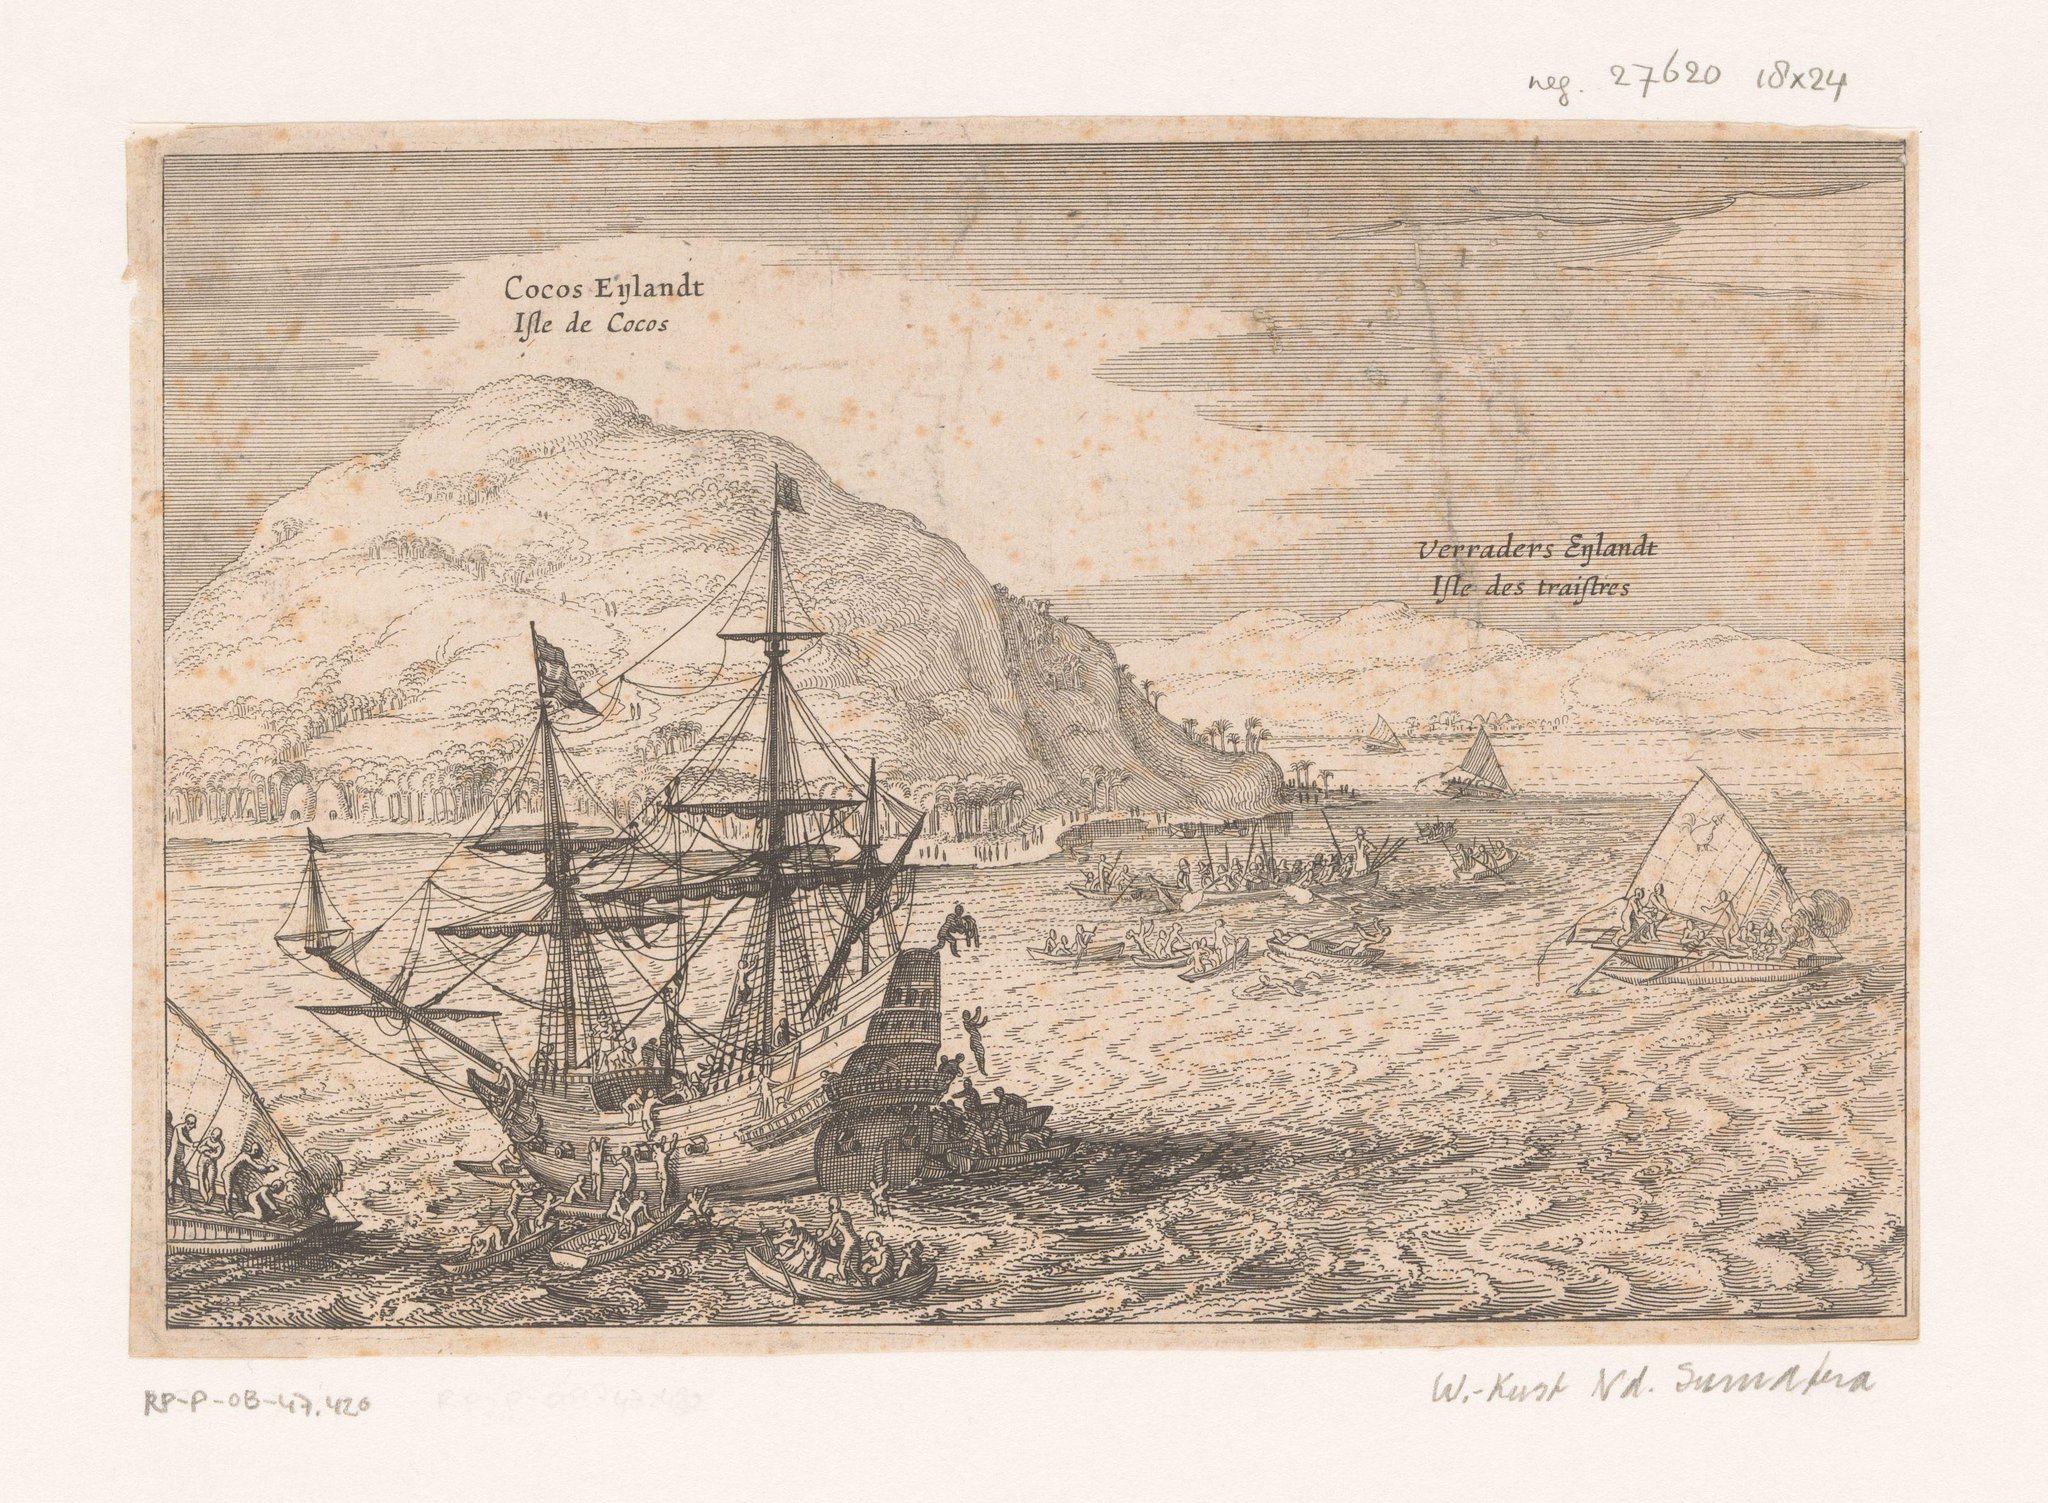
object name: print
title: Cocos Eylandt / Verraders Eylandt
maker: Anonymous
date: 1616-1625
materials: paper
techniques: etching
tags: island, ships (in general), attack ~ siege, sumatra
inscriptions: collector's mark, collector's mark: Lugt 2228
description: Het schip de Eendracht bij Cocos eiland, mei 1616. Schermutselingen met de lokale bevolking die op het schip klimt.